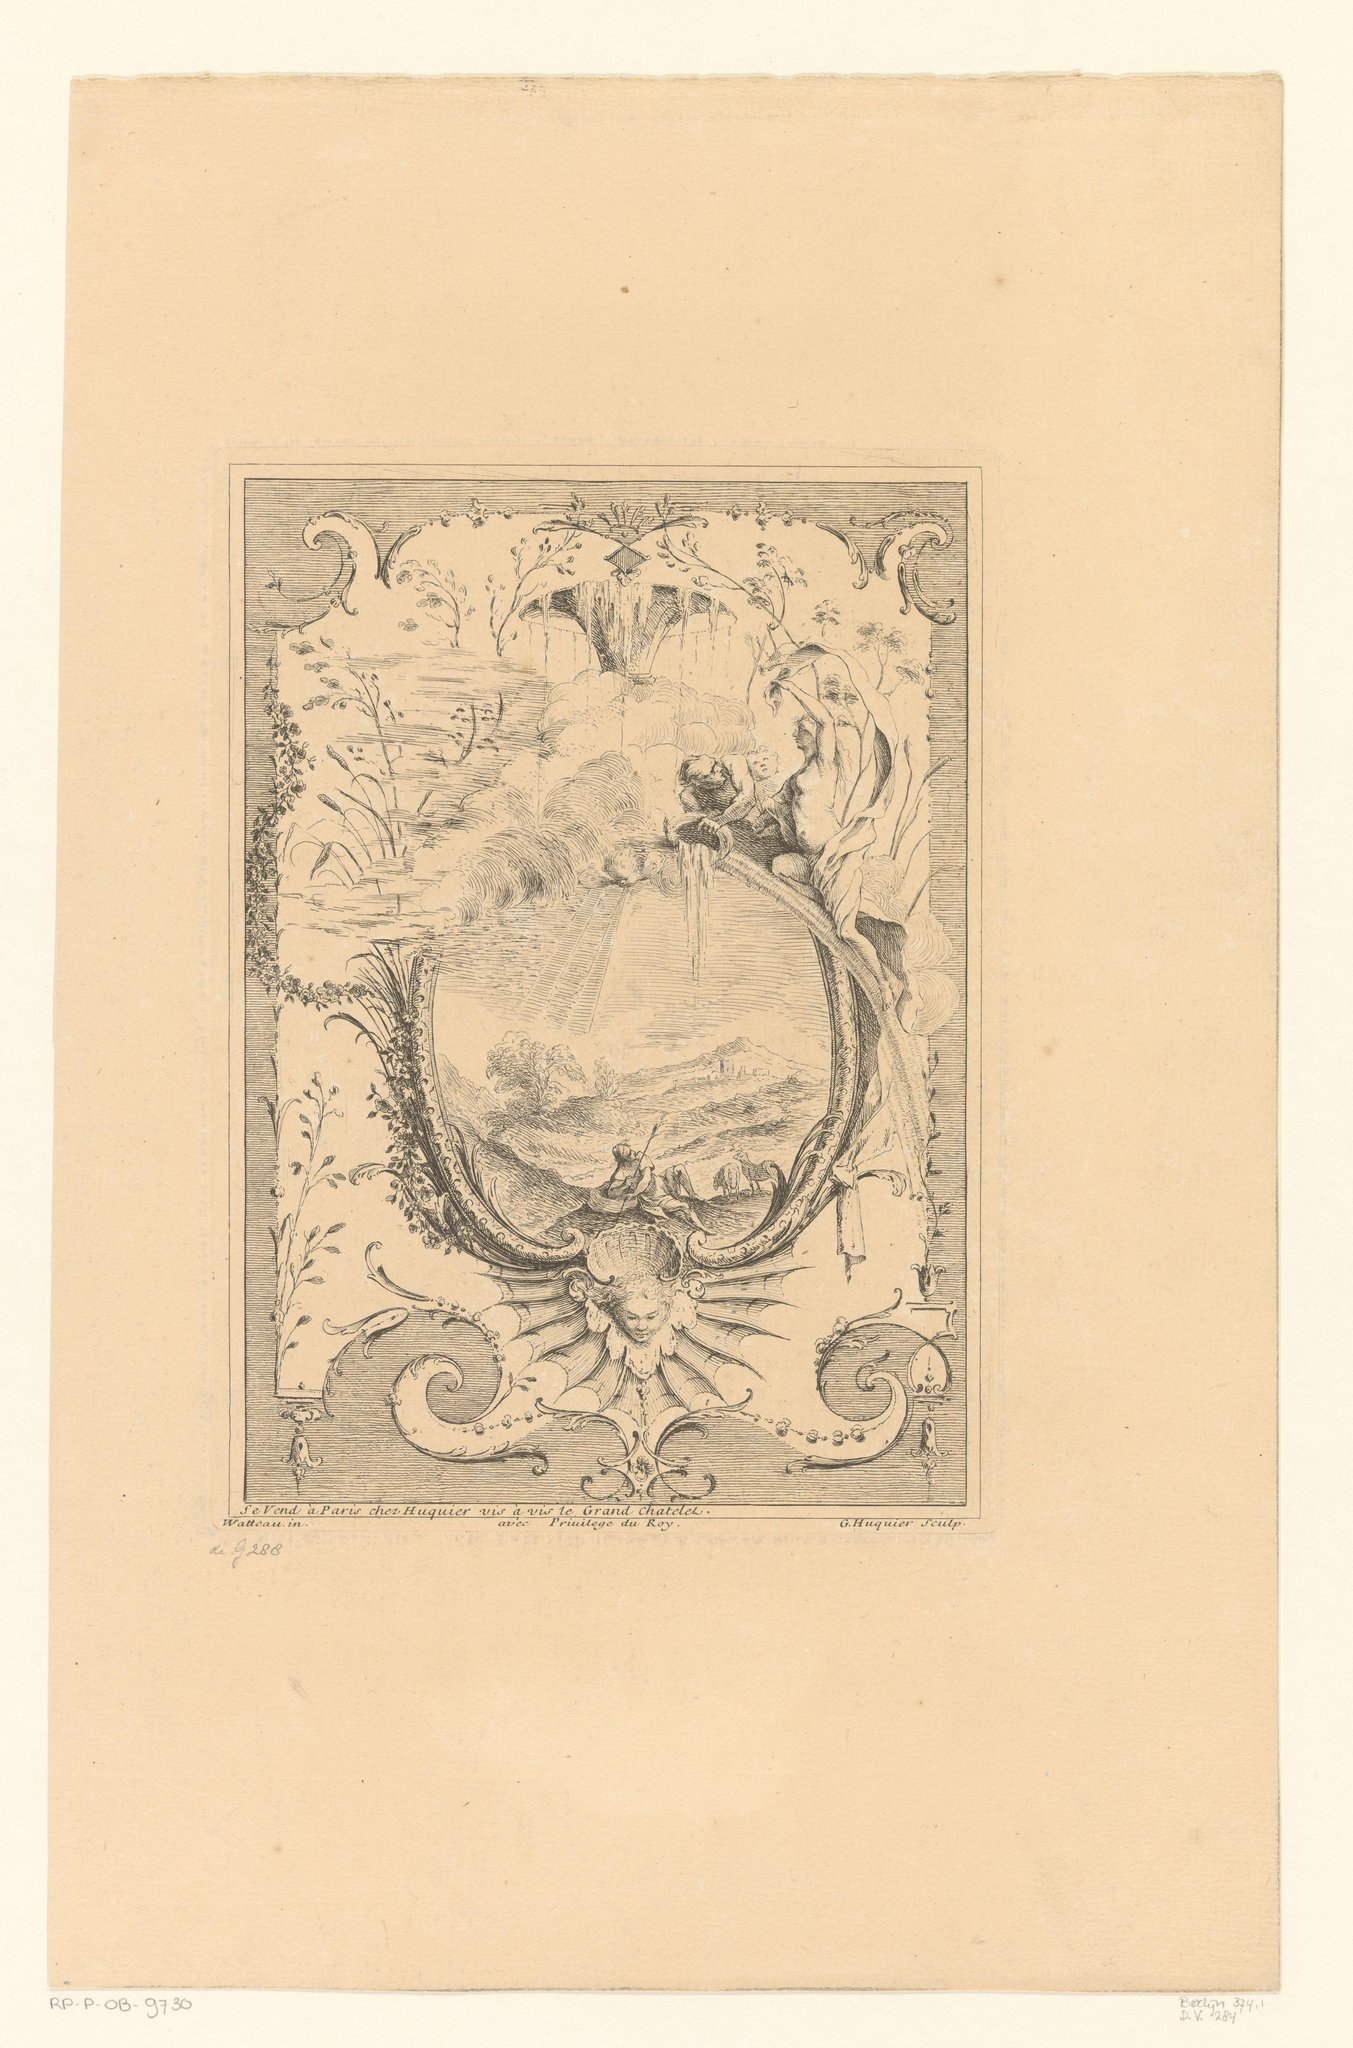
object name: print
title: Allegorie van de regen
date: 1729-1737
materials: paper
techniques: etching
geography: paris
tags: rain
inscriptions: collector's mark: Lugt 2228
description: Een medaillon met een herder zittend in een landschap. Boven hem hangen regenwolken. Aan de bovenzijde een fontein, wolken en drie figuren. Rondom de voorstelling een rocaille omlijsting.